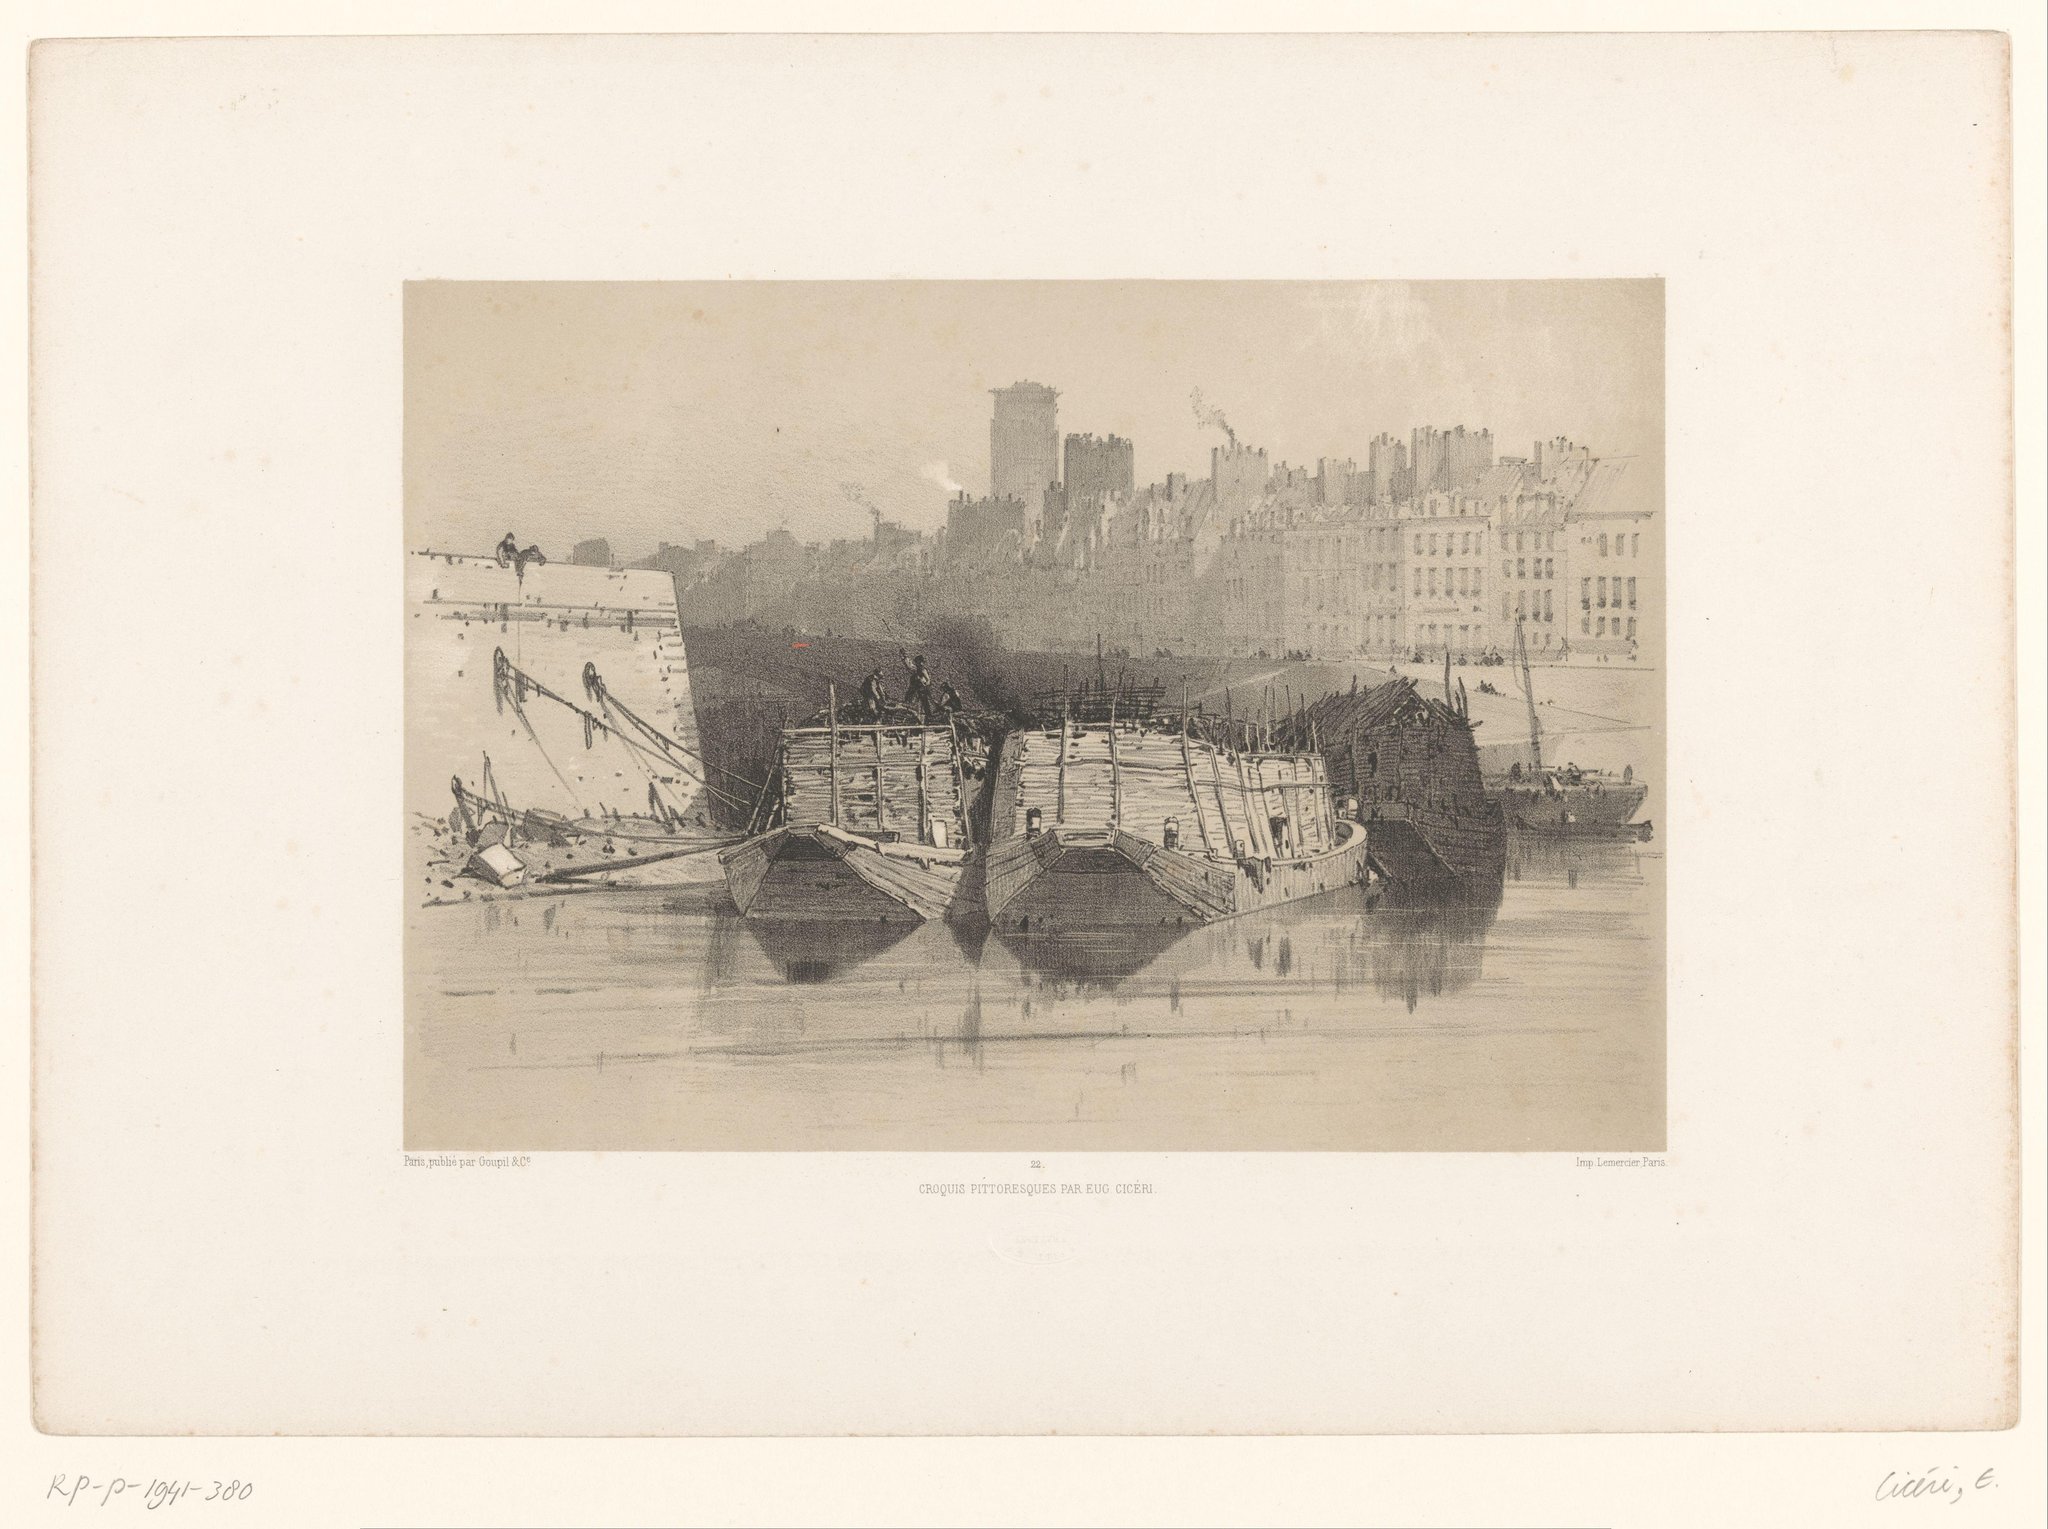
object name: print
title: Croquis pittoresques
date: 1854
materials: paper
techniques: tone lithography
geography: paris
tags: bridge in city across river, canal, etc. (+ city(-scape) with figures, staffage), boat propelled by man or animal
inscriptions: collector's mark: Lugt 2760, check stamp: Lugt 1090, collector's mark: Lugt 2228a